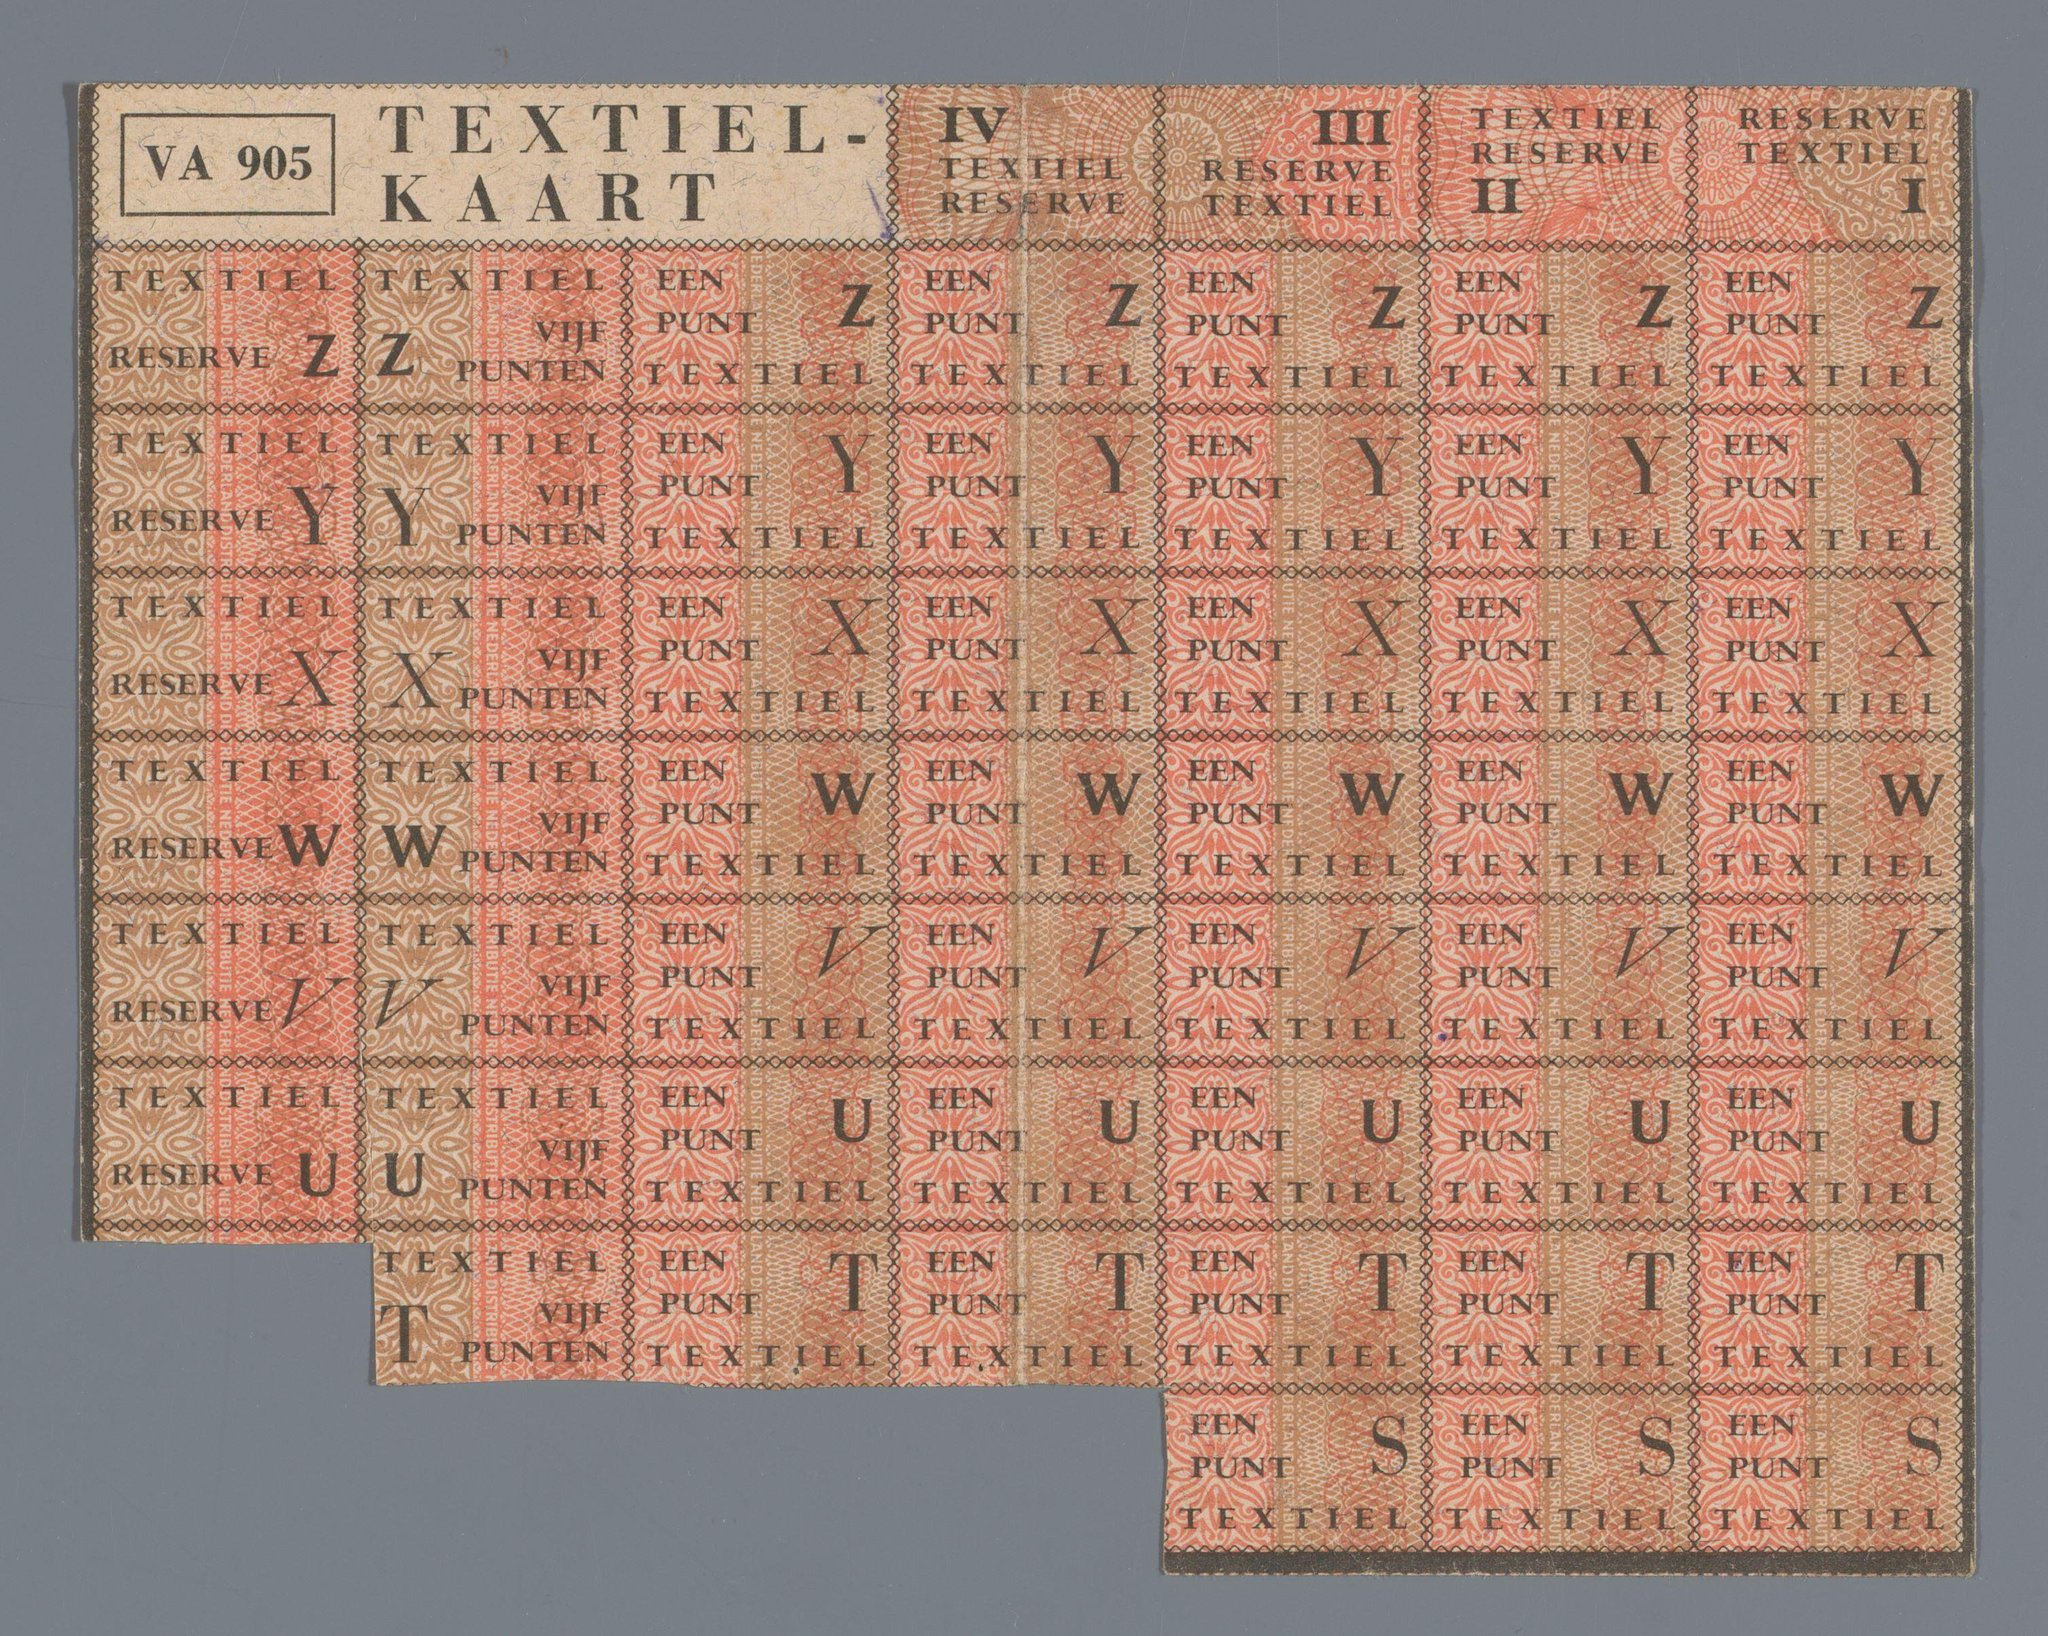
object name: voucher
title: Textielkaart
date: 1940-1945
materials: paper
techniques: printing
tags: netherlands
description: Bonkaart voor textiel ('VA905 Textielkaart) voor een klein gedeelte aangebroken. Op de achterkant: met paars potlood geschreven: H.J.M. van Dungen Sr, Warmondstraat 152 hs, Amsterdam-W.